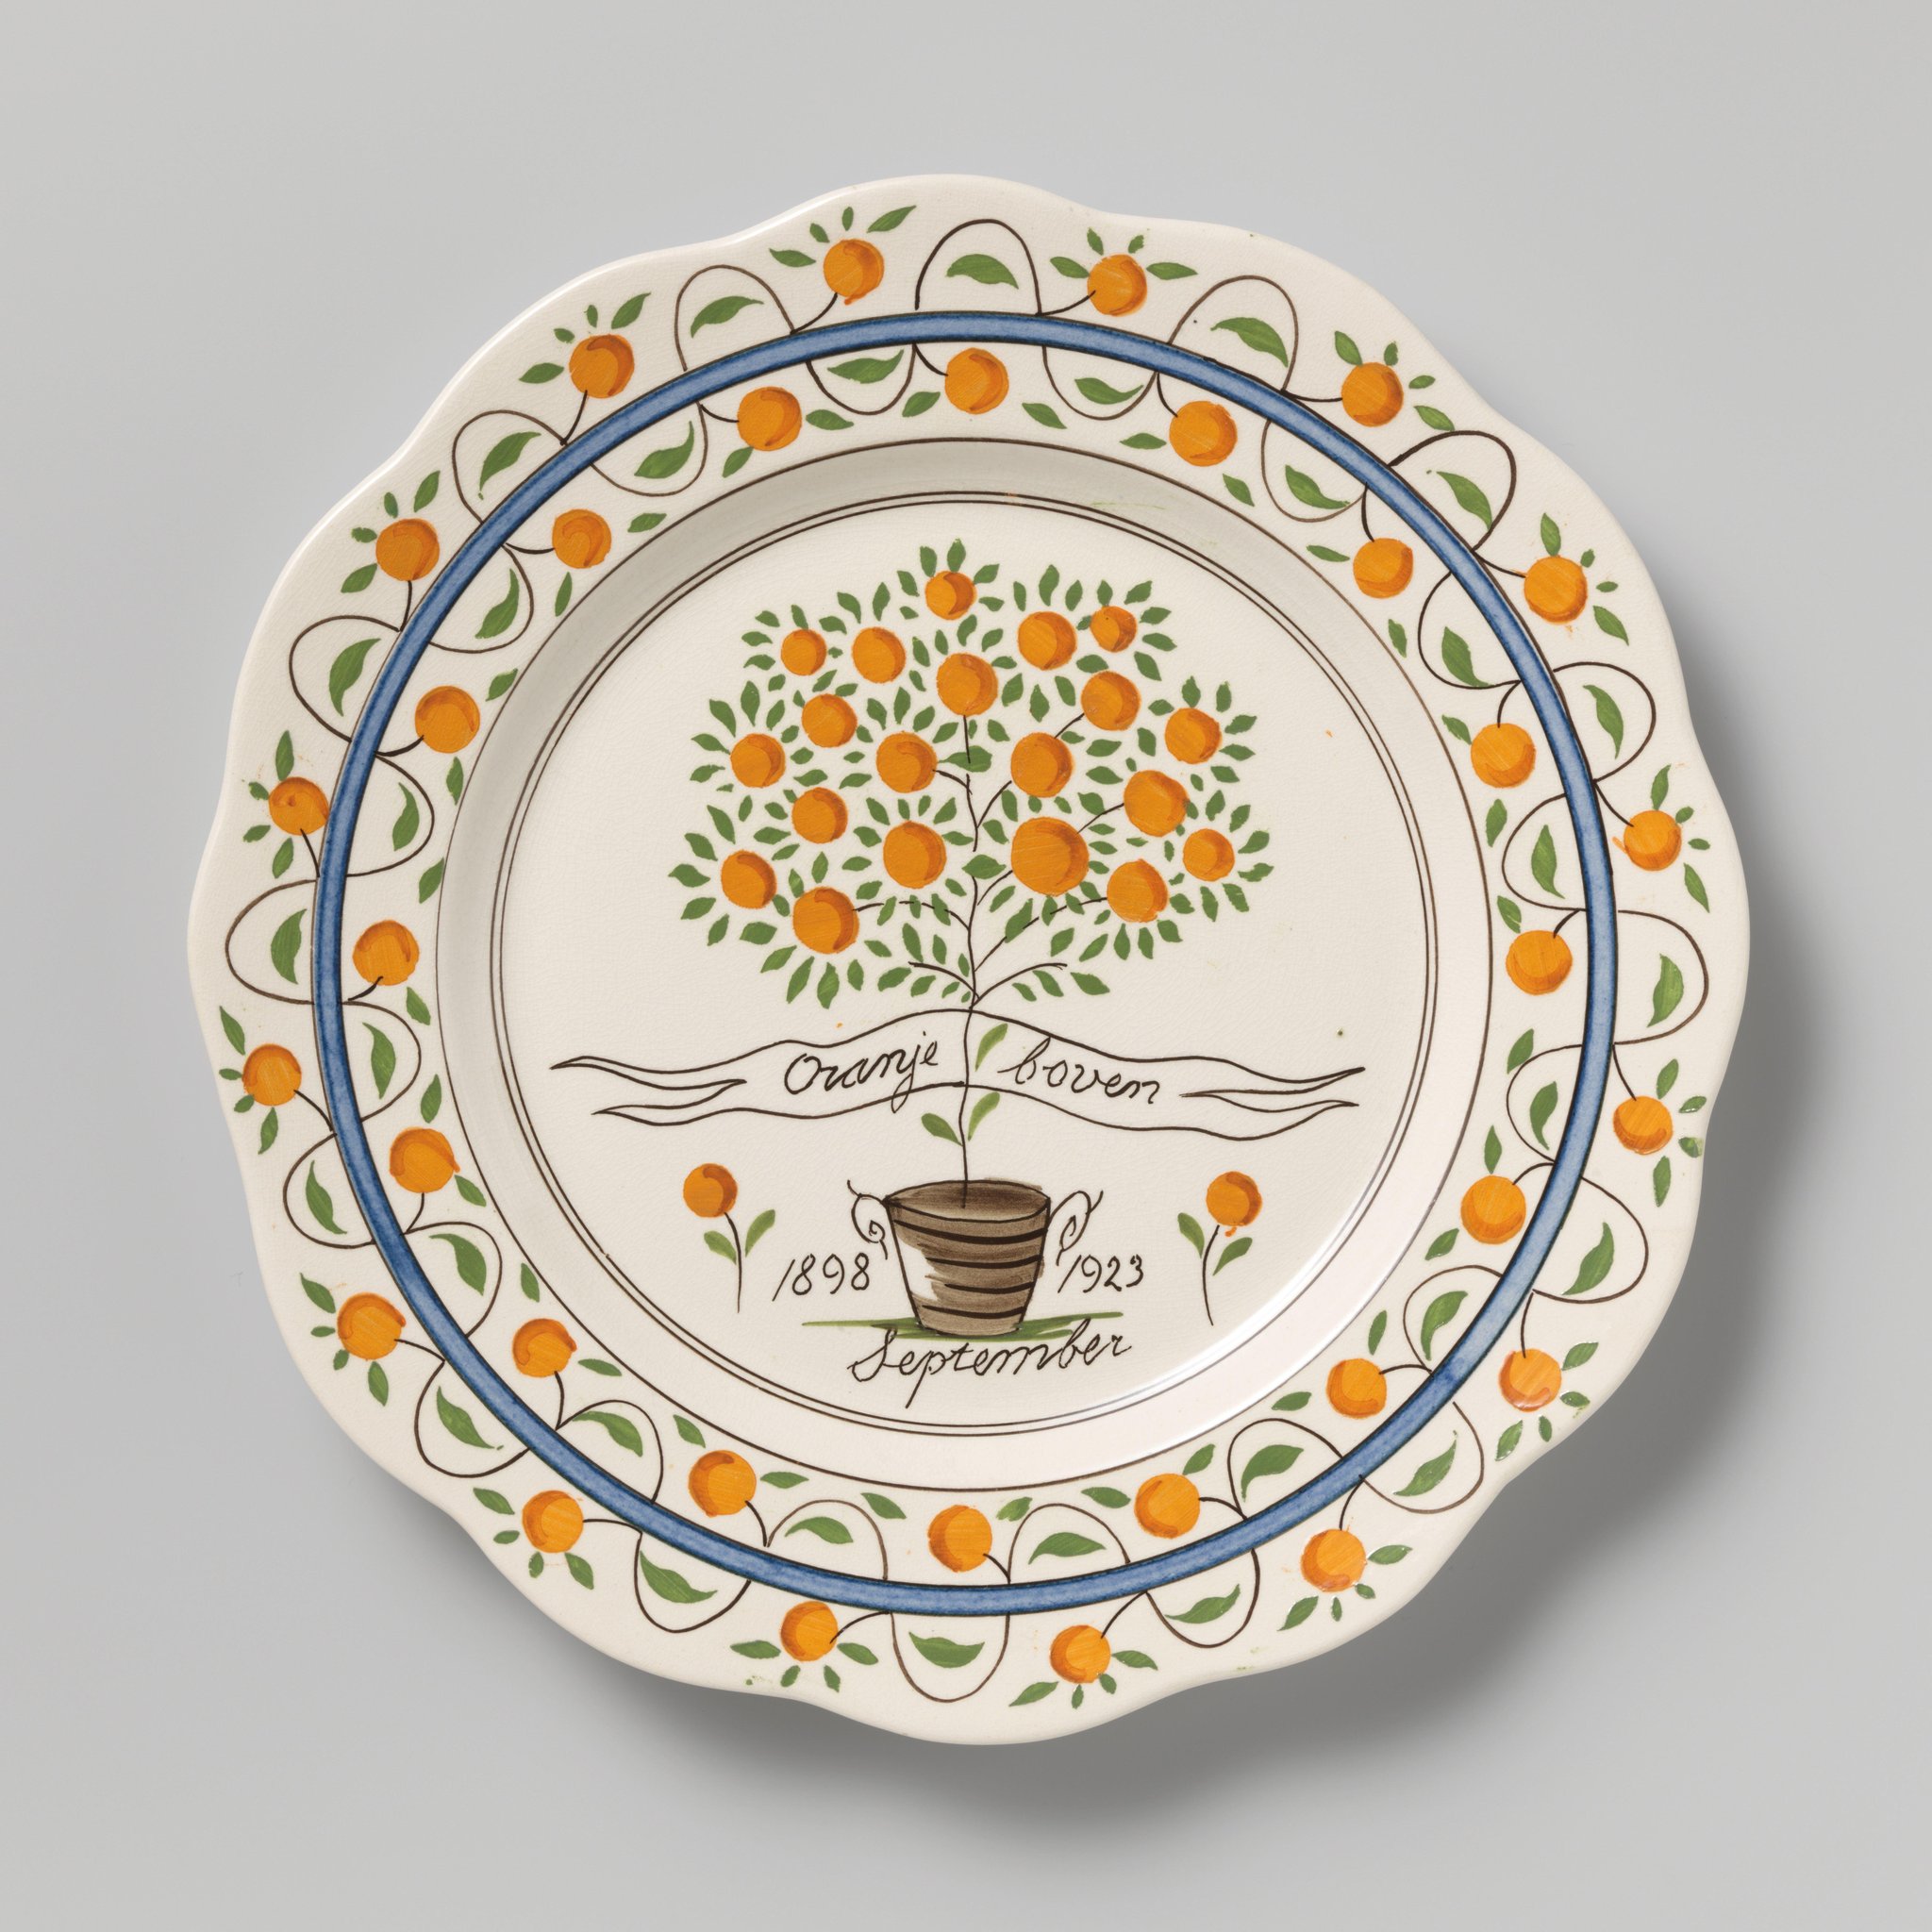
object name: plate dish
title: Herinneringsbord zilveren regeringsjubileum van koningin Wilhelmina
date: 1923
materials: earthenware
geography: gouda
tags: the hague, print maker, wilhelmina of the netherlands, netherlands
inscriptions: mark: ‘Plateelbakkerij Zuid-Holland’, inscription: ‘Oranje boven 1898-1923. September’, mark: ‘A [...] .K. [aan weerszijden van het fabrieksmerk]’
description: Herinneringsbord versierd in oranje en groen, ter herinnering aan het zilveren regeringsjubileum van koningin Wilhelmina; doek met het opschrift:" Oranje boven 1898-1923. September." Gelobde rand met oranje-appelen.